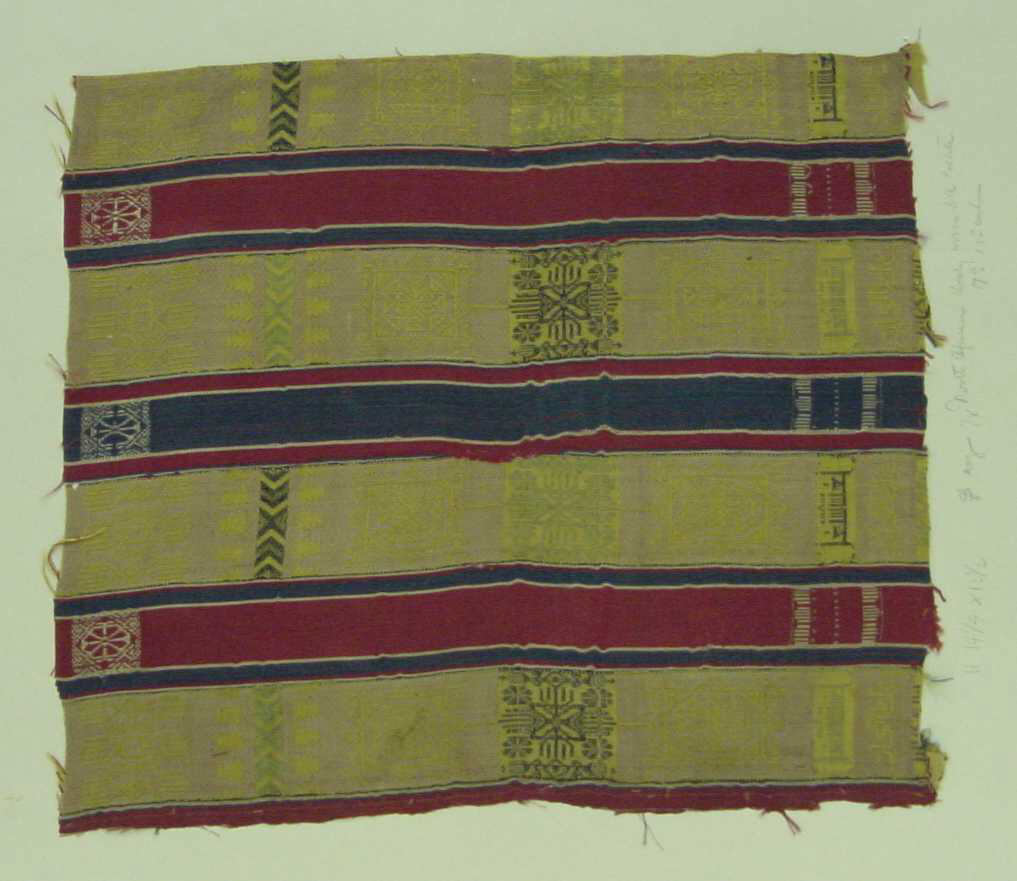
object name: textile fragment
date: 1701-1800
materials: silk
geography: north africa